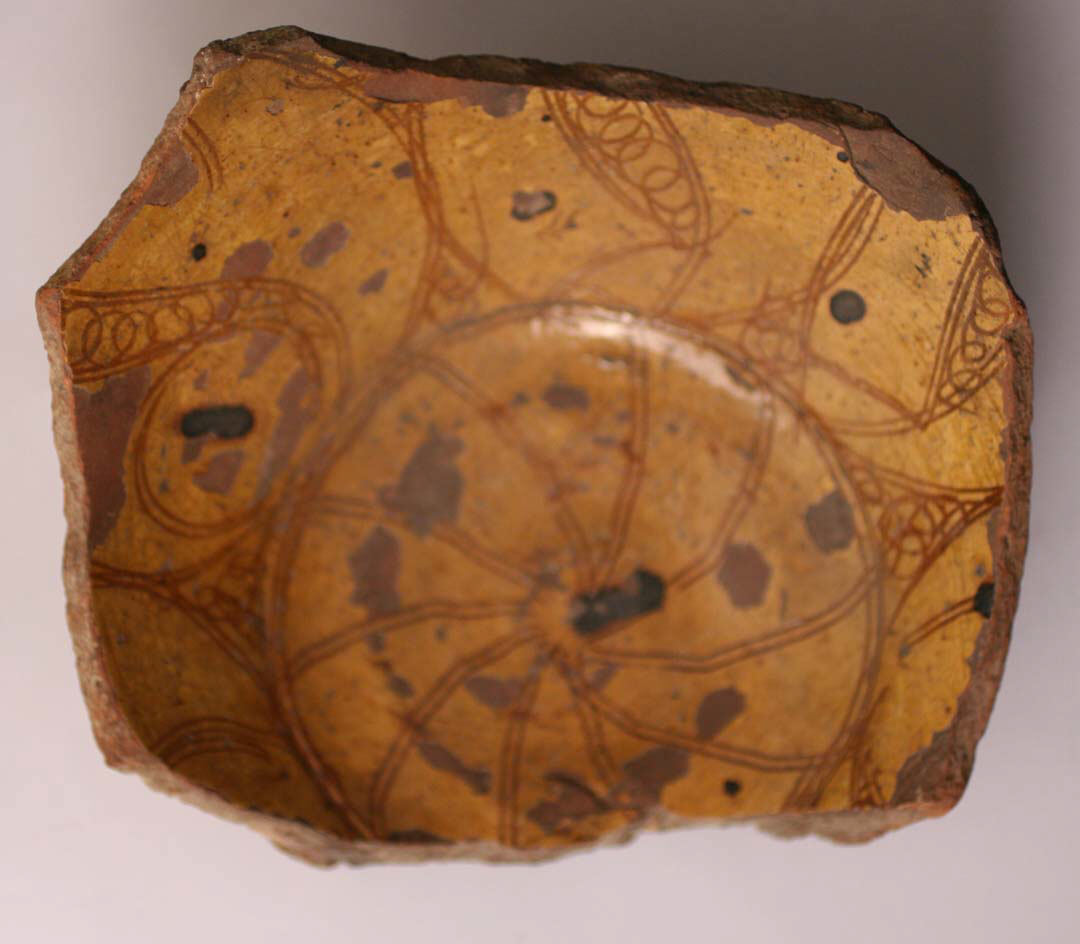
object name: ceramic fragment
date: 1301-1500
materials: earthenware, glaze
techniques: coloring, incising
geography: egypt